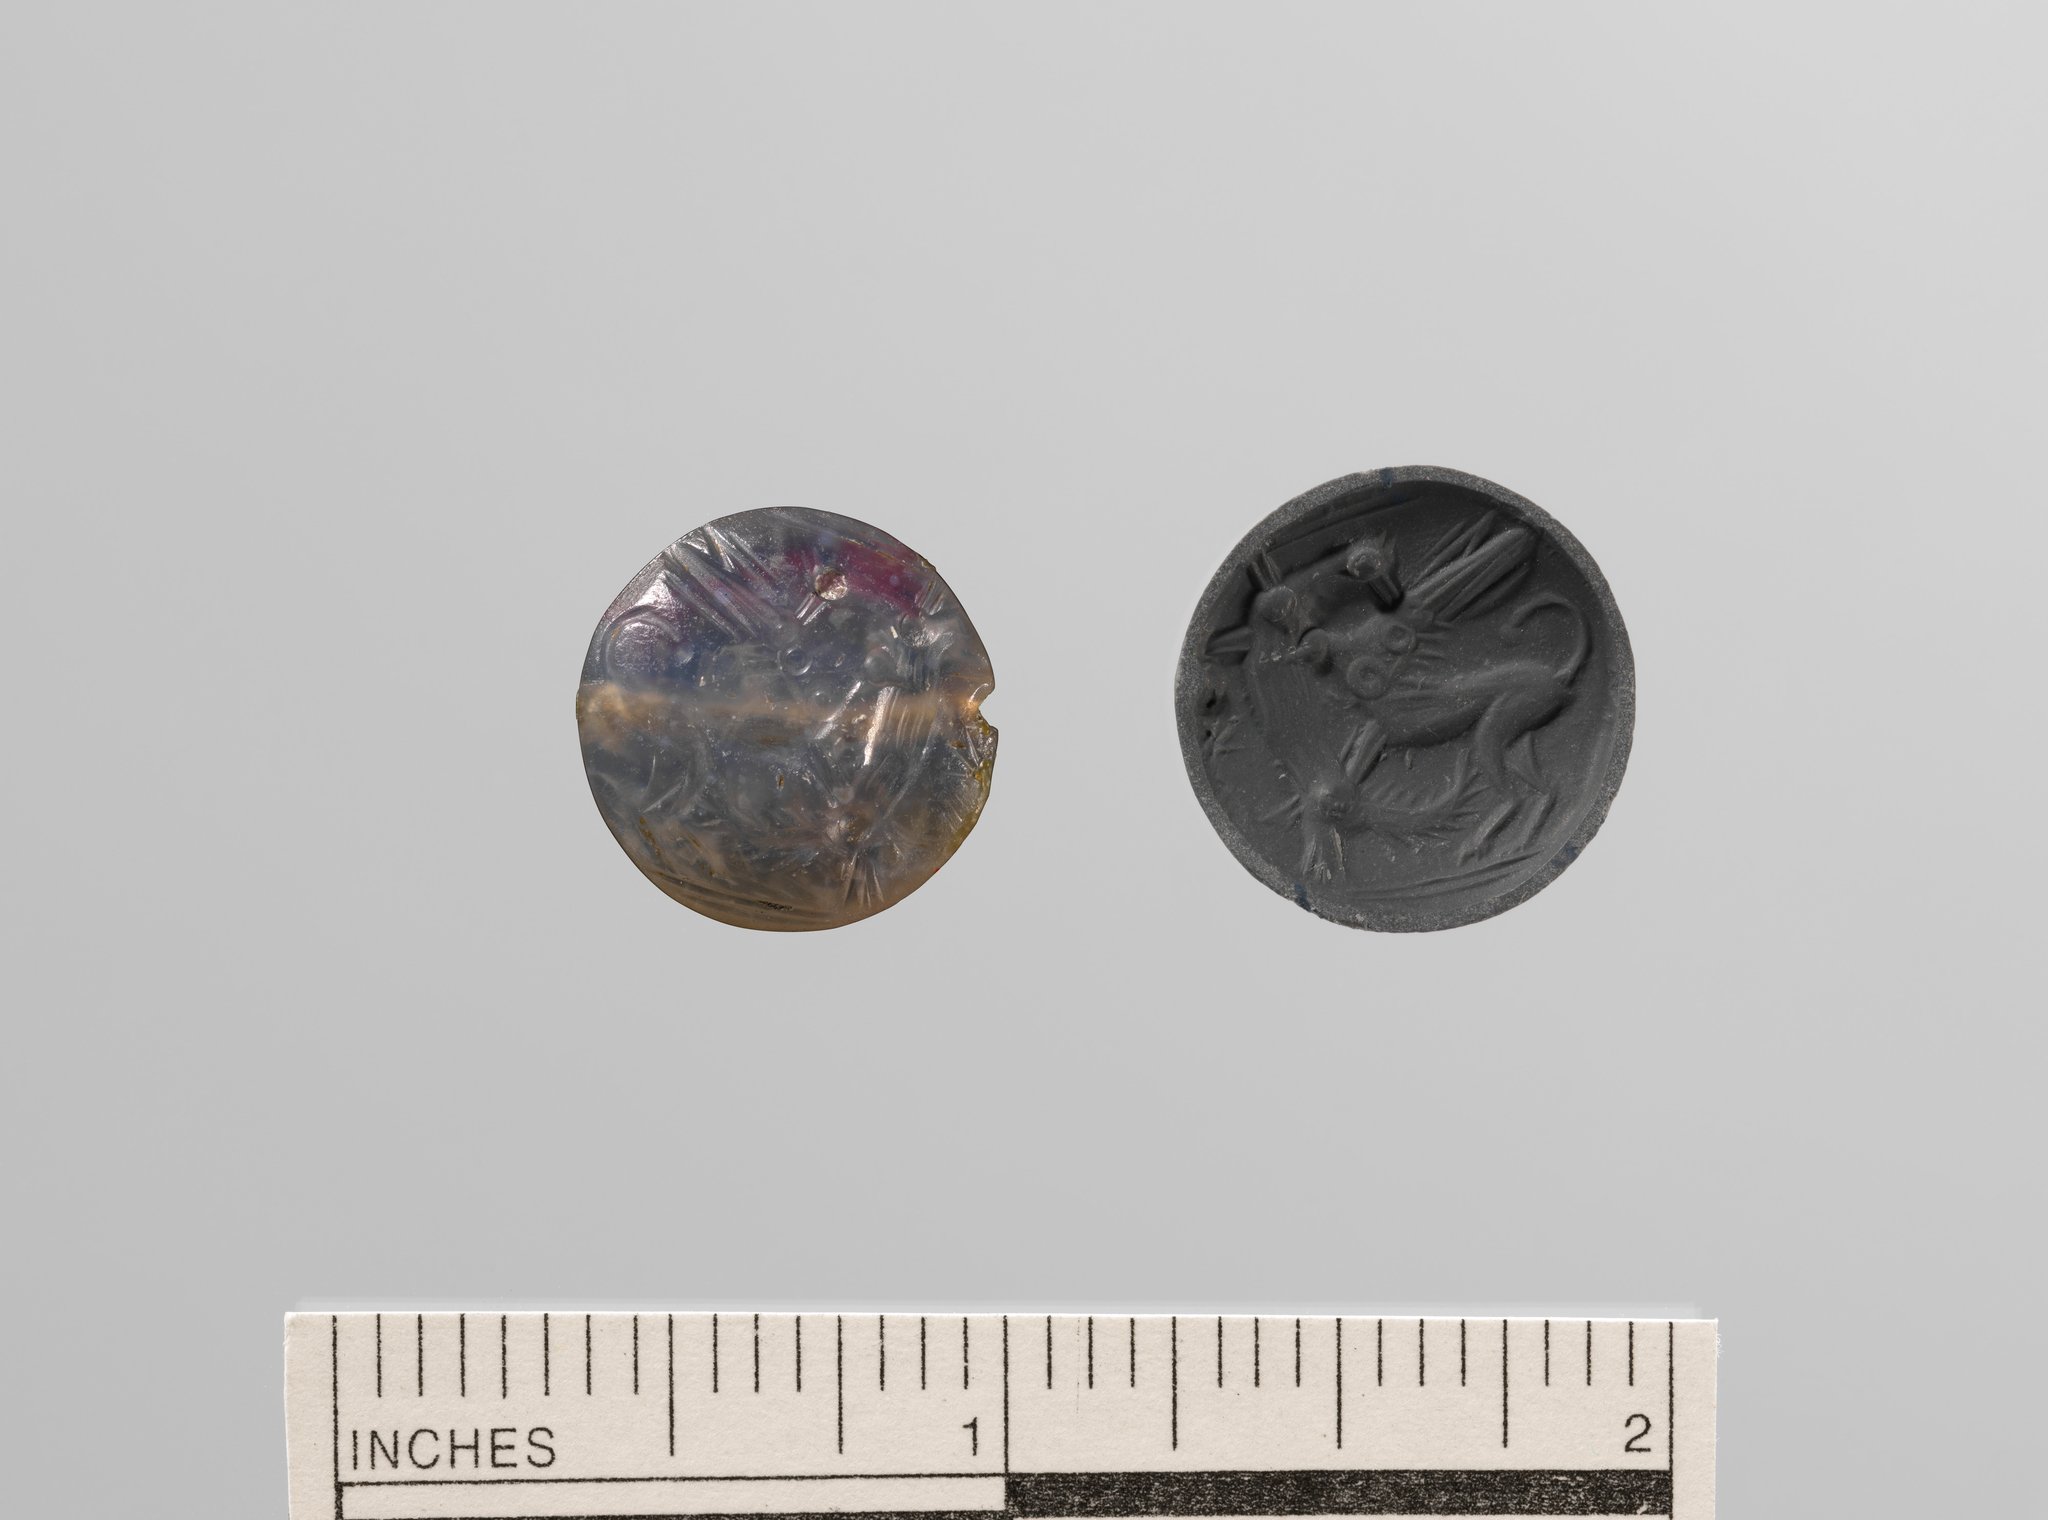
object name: seal, lentoid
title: Amethyst lentoid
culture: minoan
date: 1600-1500 BCE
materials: gemstone